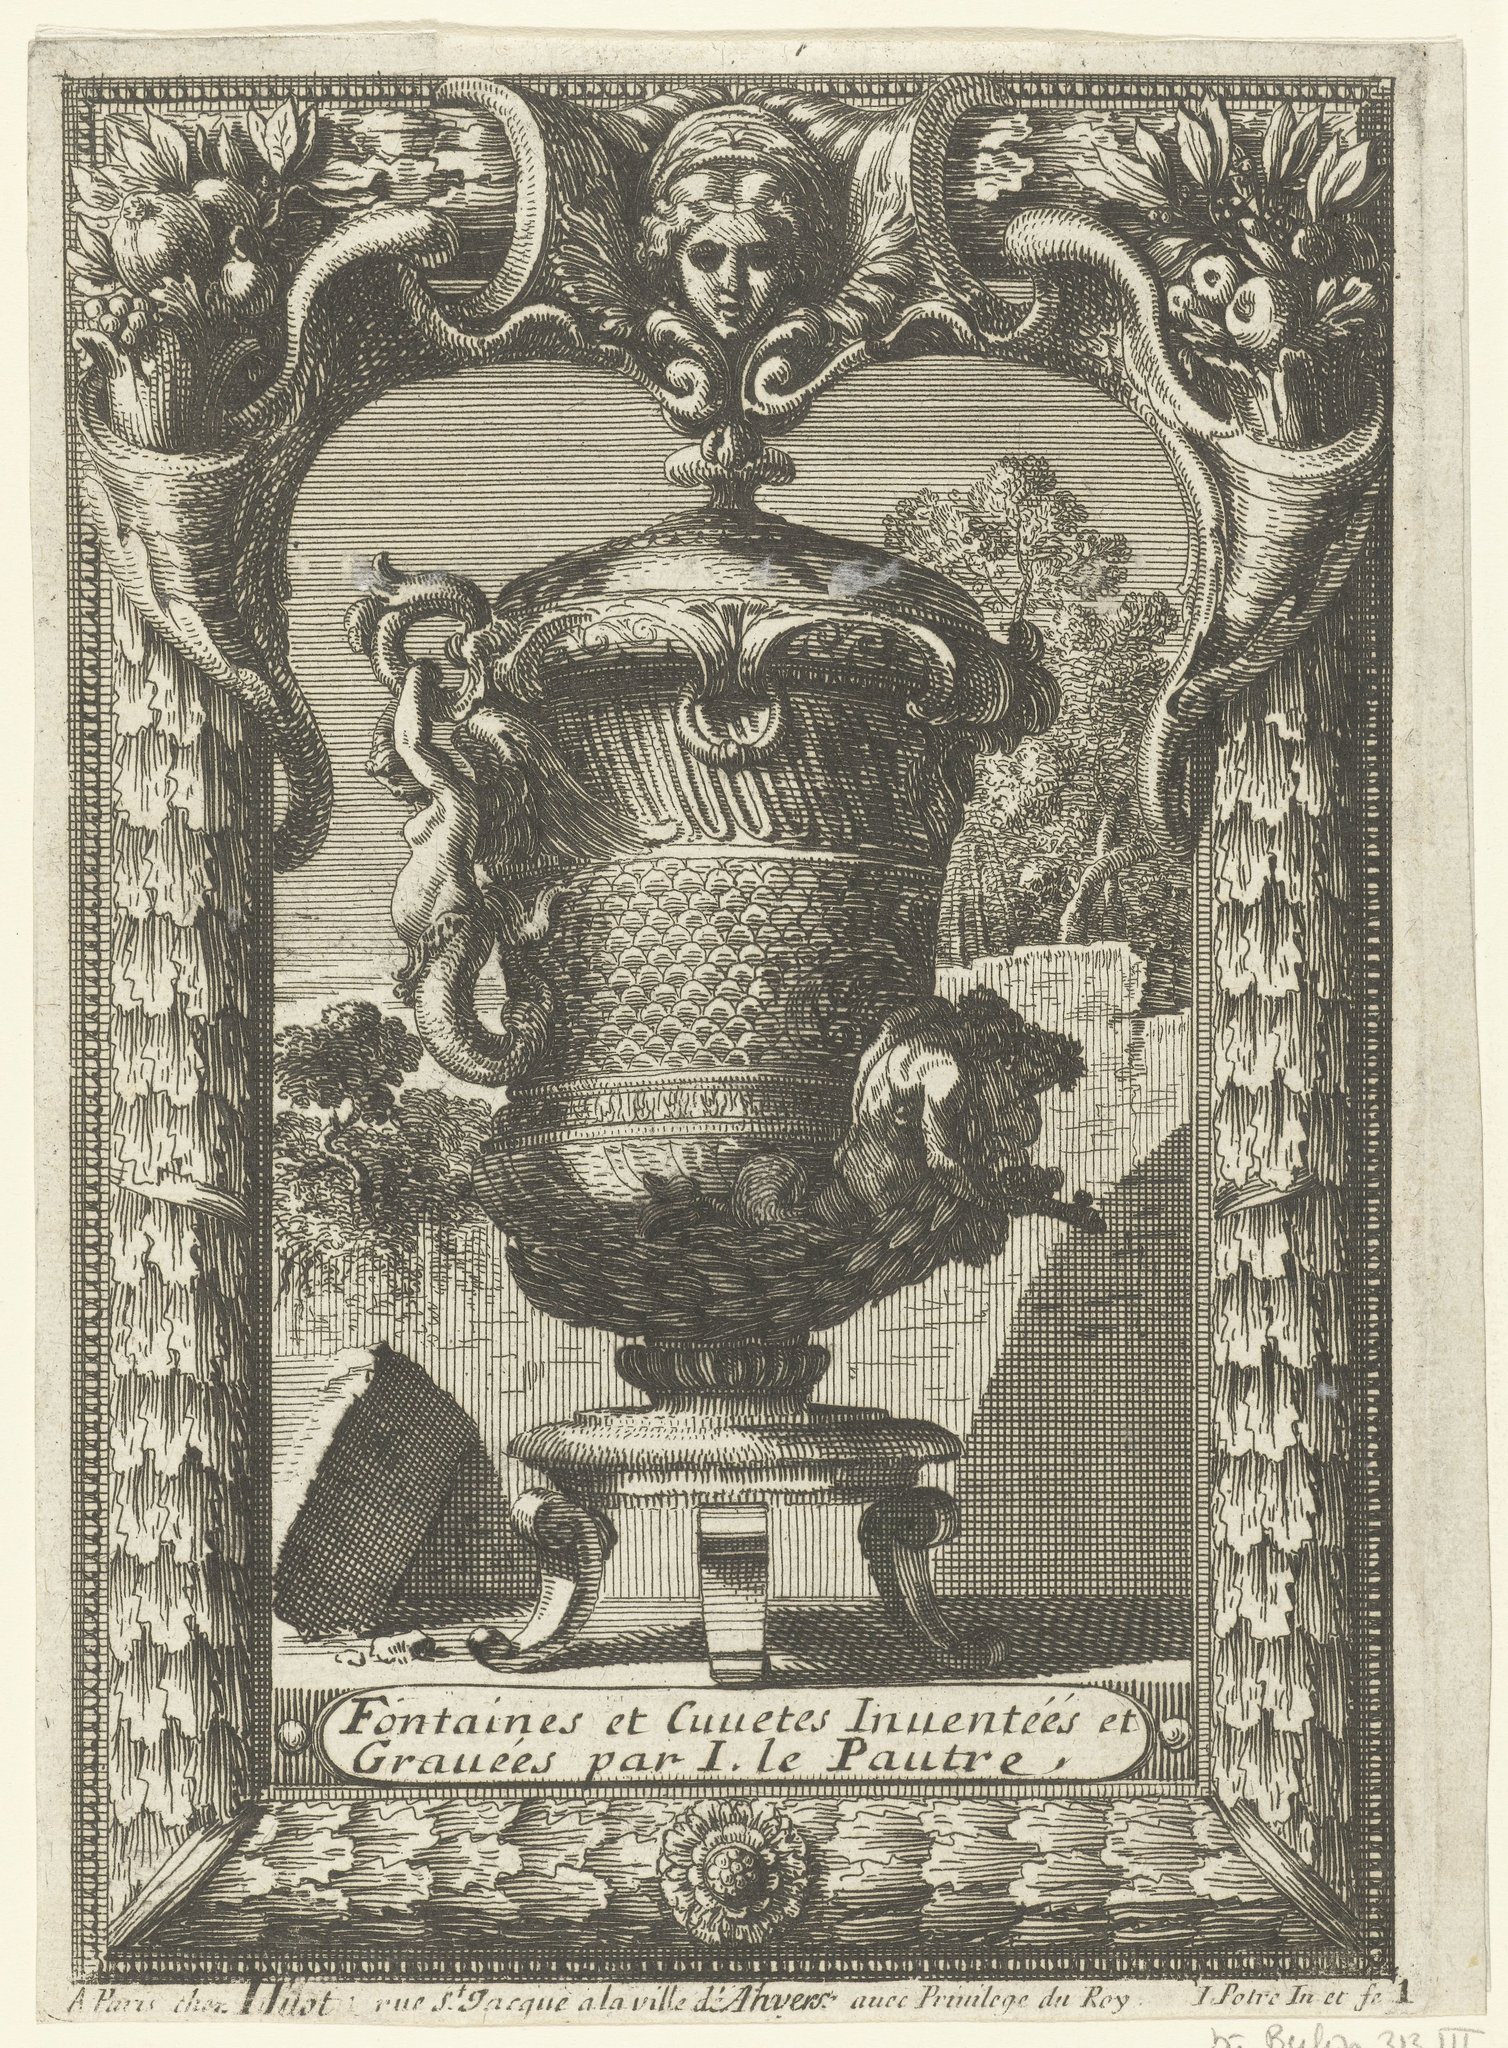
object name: titelblad, titelpagina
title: Titelblad: Fontaines et Cuuettes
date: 1700-1800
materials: paper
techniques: etching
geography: france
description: Mobiele waterfontein op een driepoot, onderaan staat de titel. Uit vijfde editie van serie met waterfonteinen en waterbassins, voor het eerst uitgegeven door Jean I Leblond.